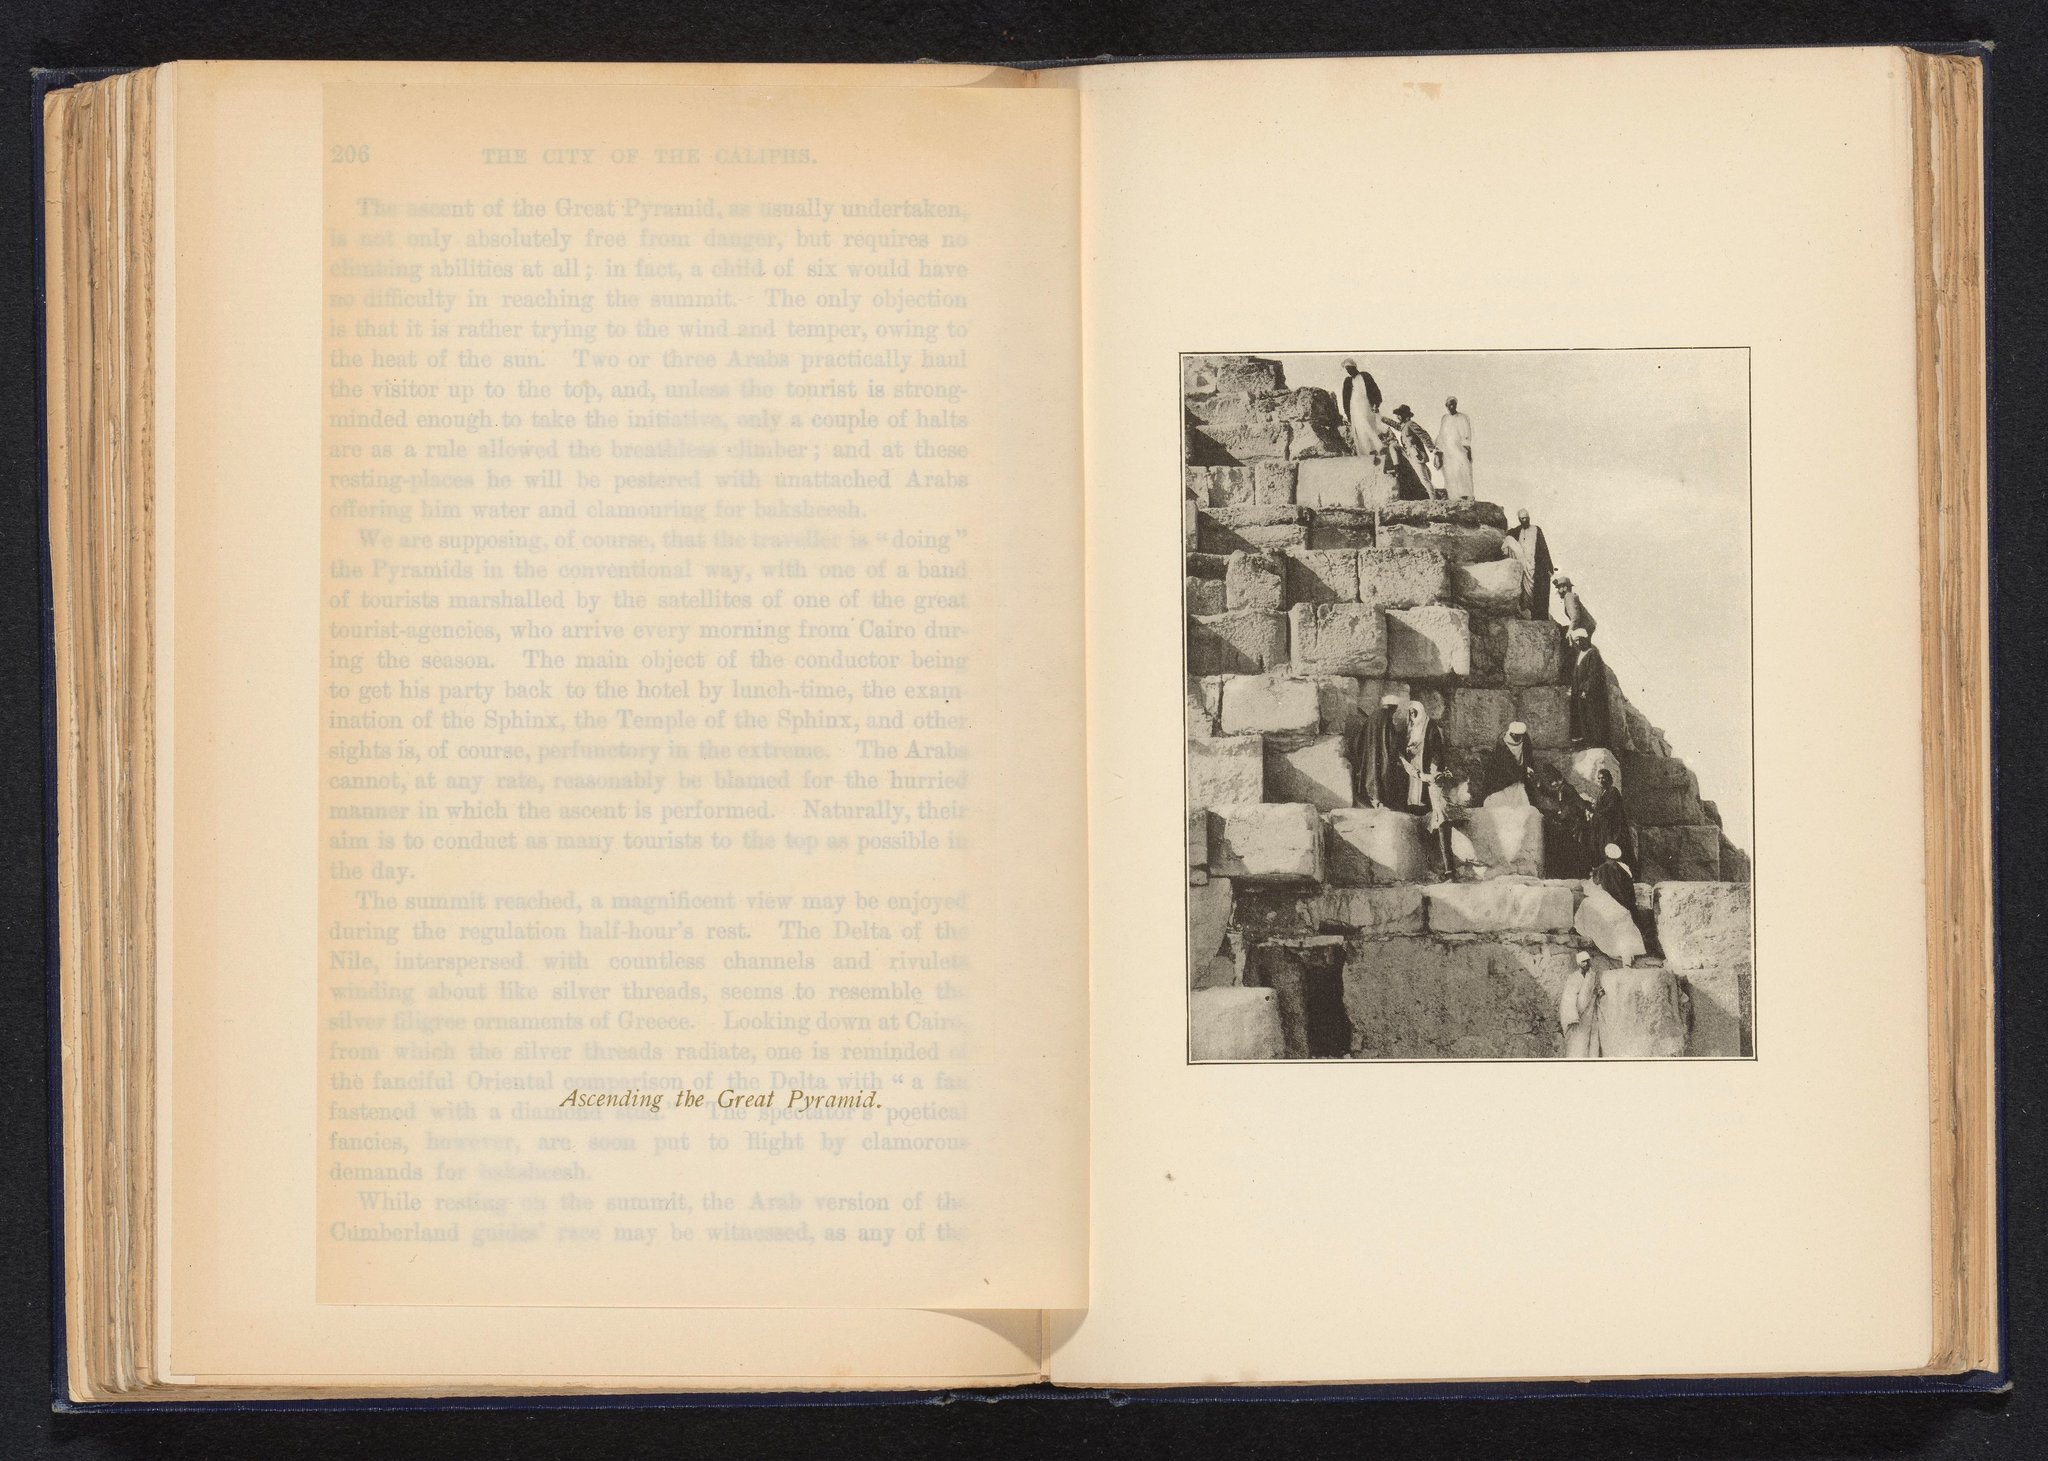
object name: photomechanical print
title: Ascending the Great Pyramid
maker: Anonymous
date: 1891-1901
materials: paper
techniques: autotype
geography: gizeh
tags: egyptian pyramids (wonder of the world)